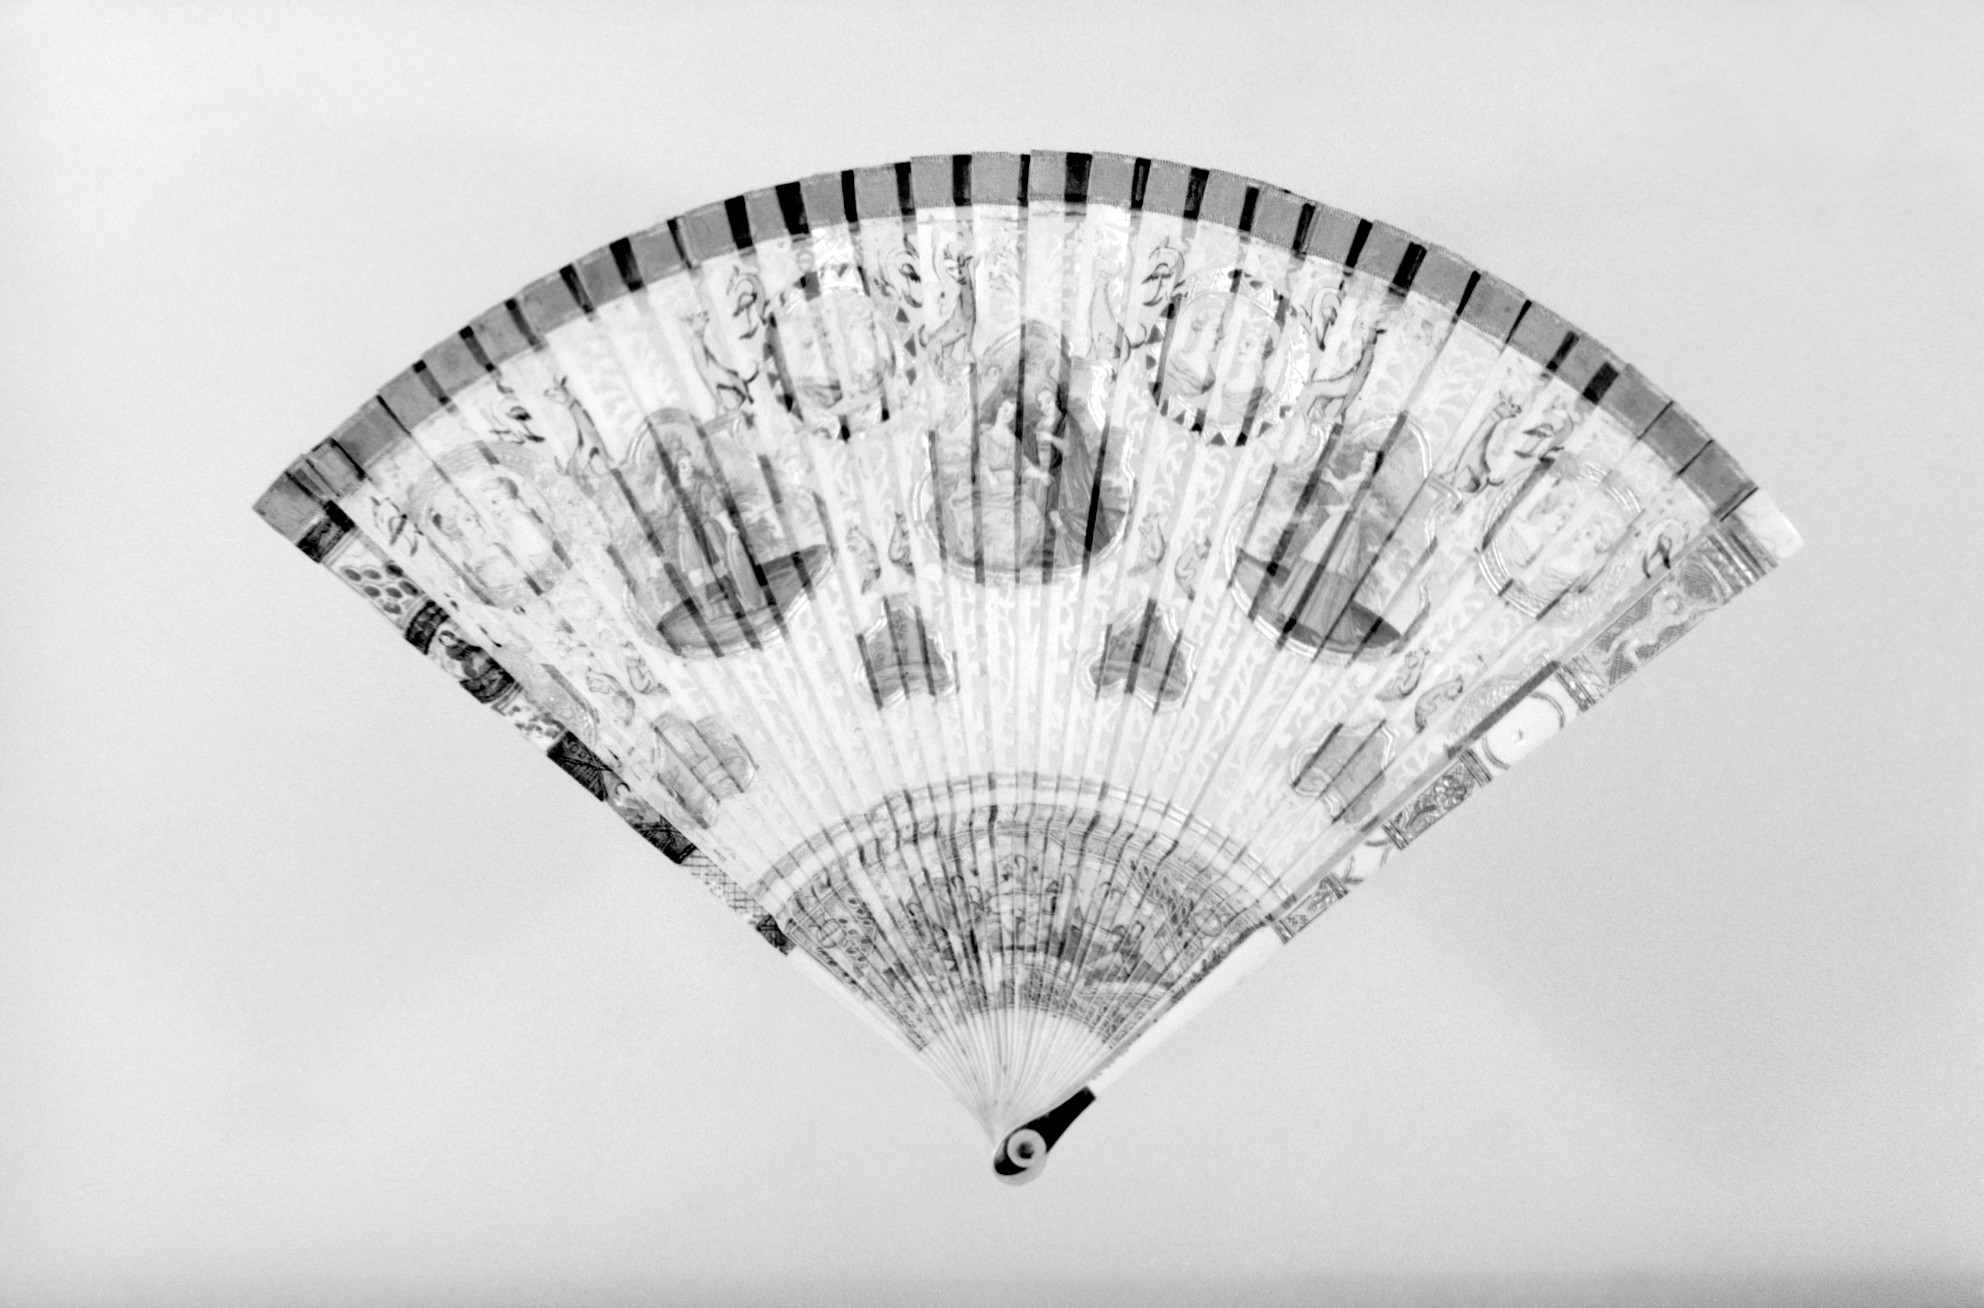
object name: fan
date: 1701-1800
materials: ivory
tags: men,women